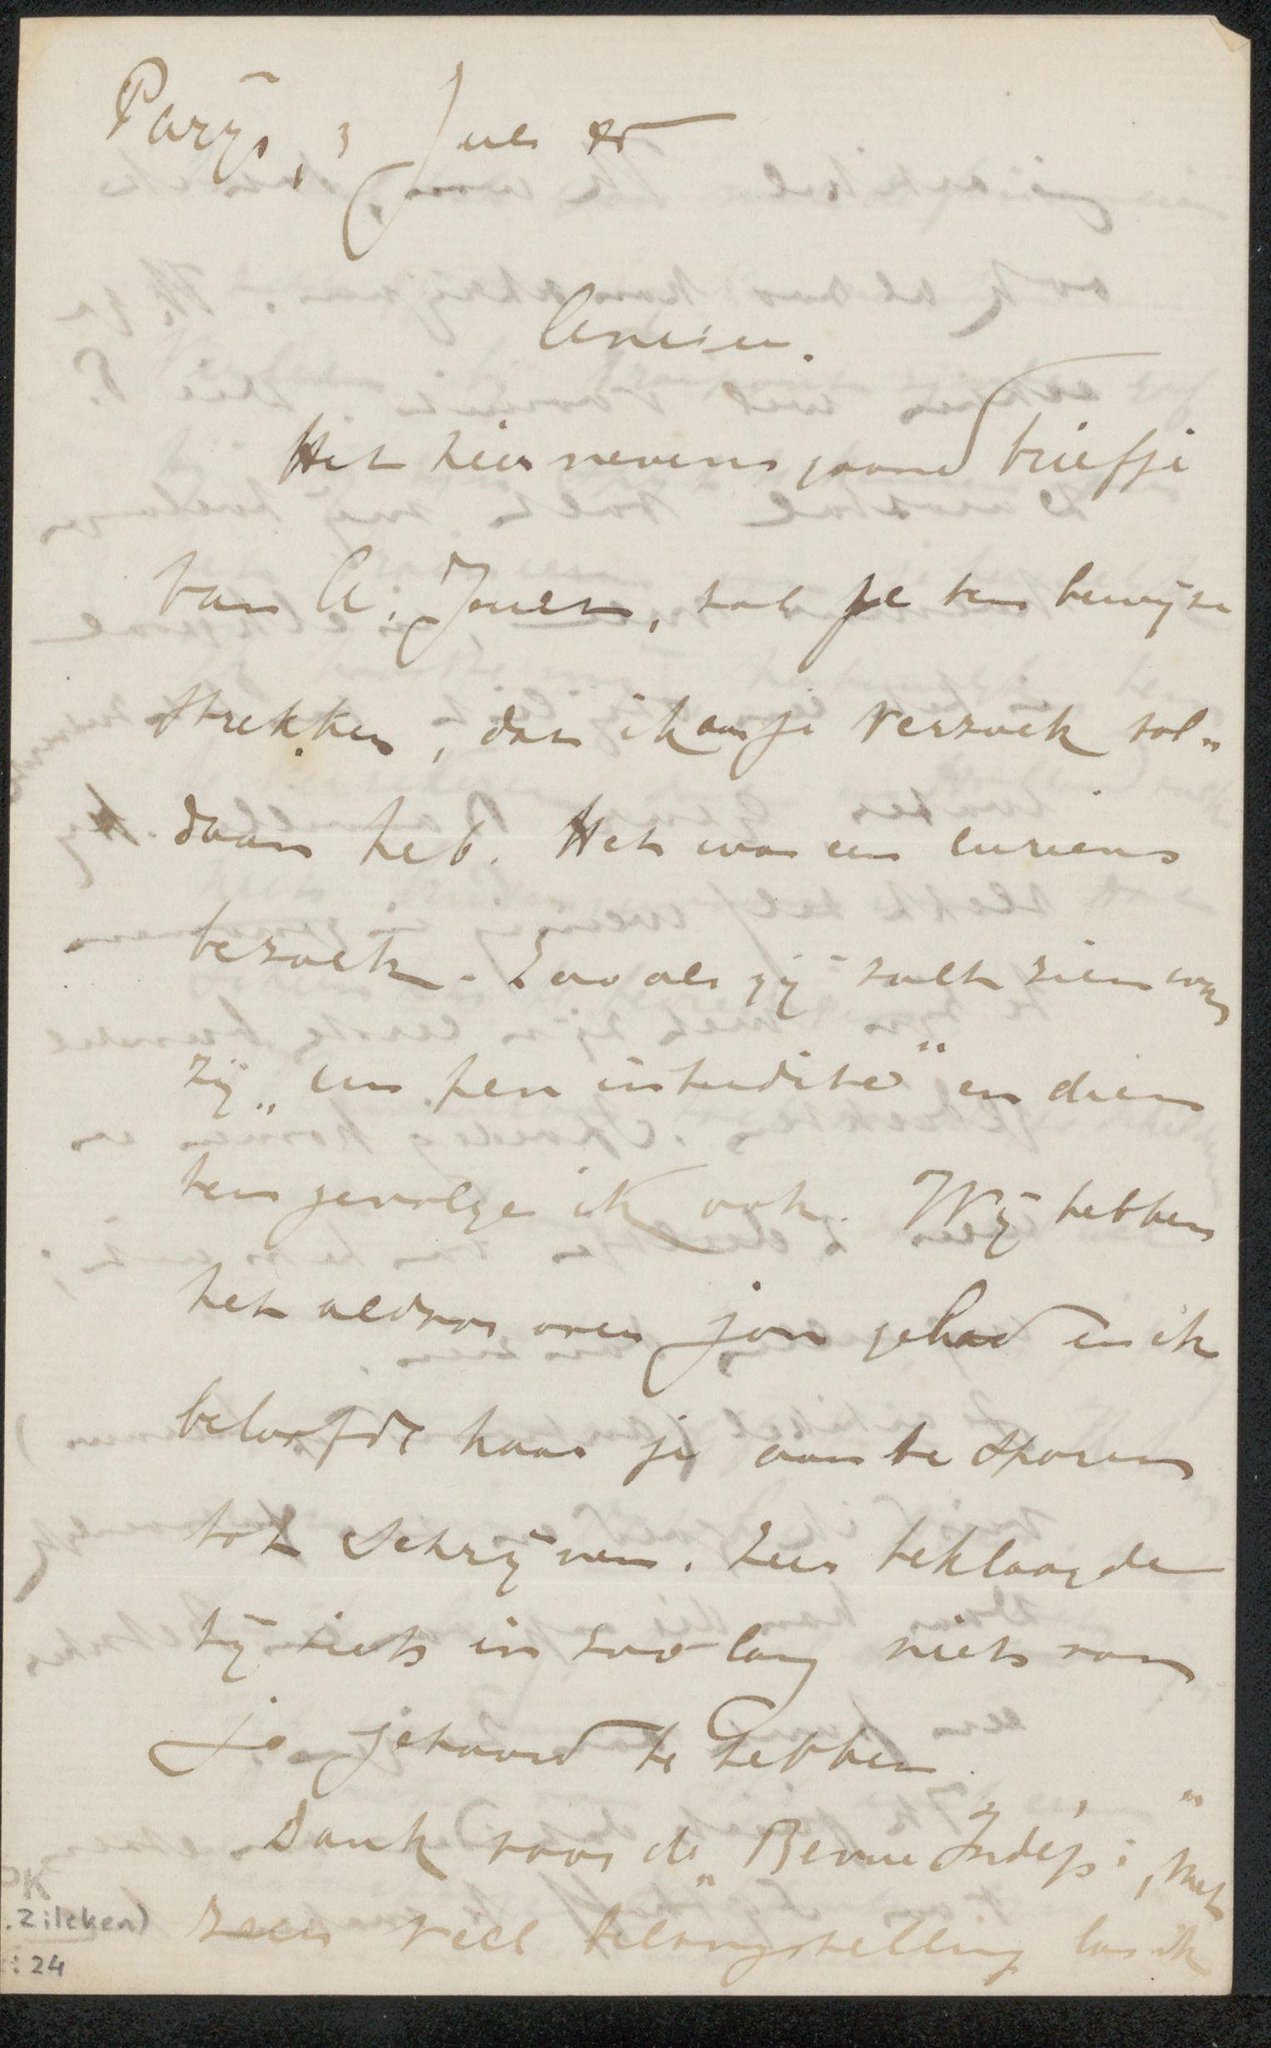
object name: letter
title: Brief aan Philip Zilcken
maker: adriaan pit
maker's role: print maker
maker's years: 1860-1944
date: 1885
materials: ink, paper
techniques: pen, writing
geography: paris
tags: dordrecht, amsterdam, print maker, draughtsman, designer, jan veth, leiden, albertus willem sijthoff, brussels, paris, painter, gustave fraipont, haarlem, frans netscher, philip zilcken, passions, emotions, affections, applied arts, arts and crafts; industrial design, the graphic arts, family life, painting (including book-illumination, miniature-painting), printed matter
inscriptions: watermark, collector's mark: ‘RPK’